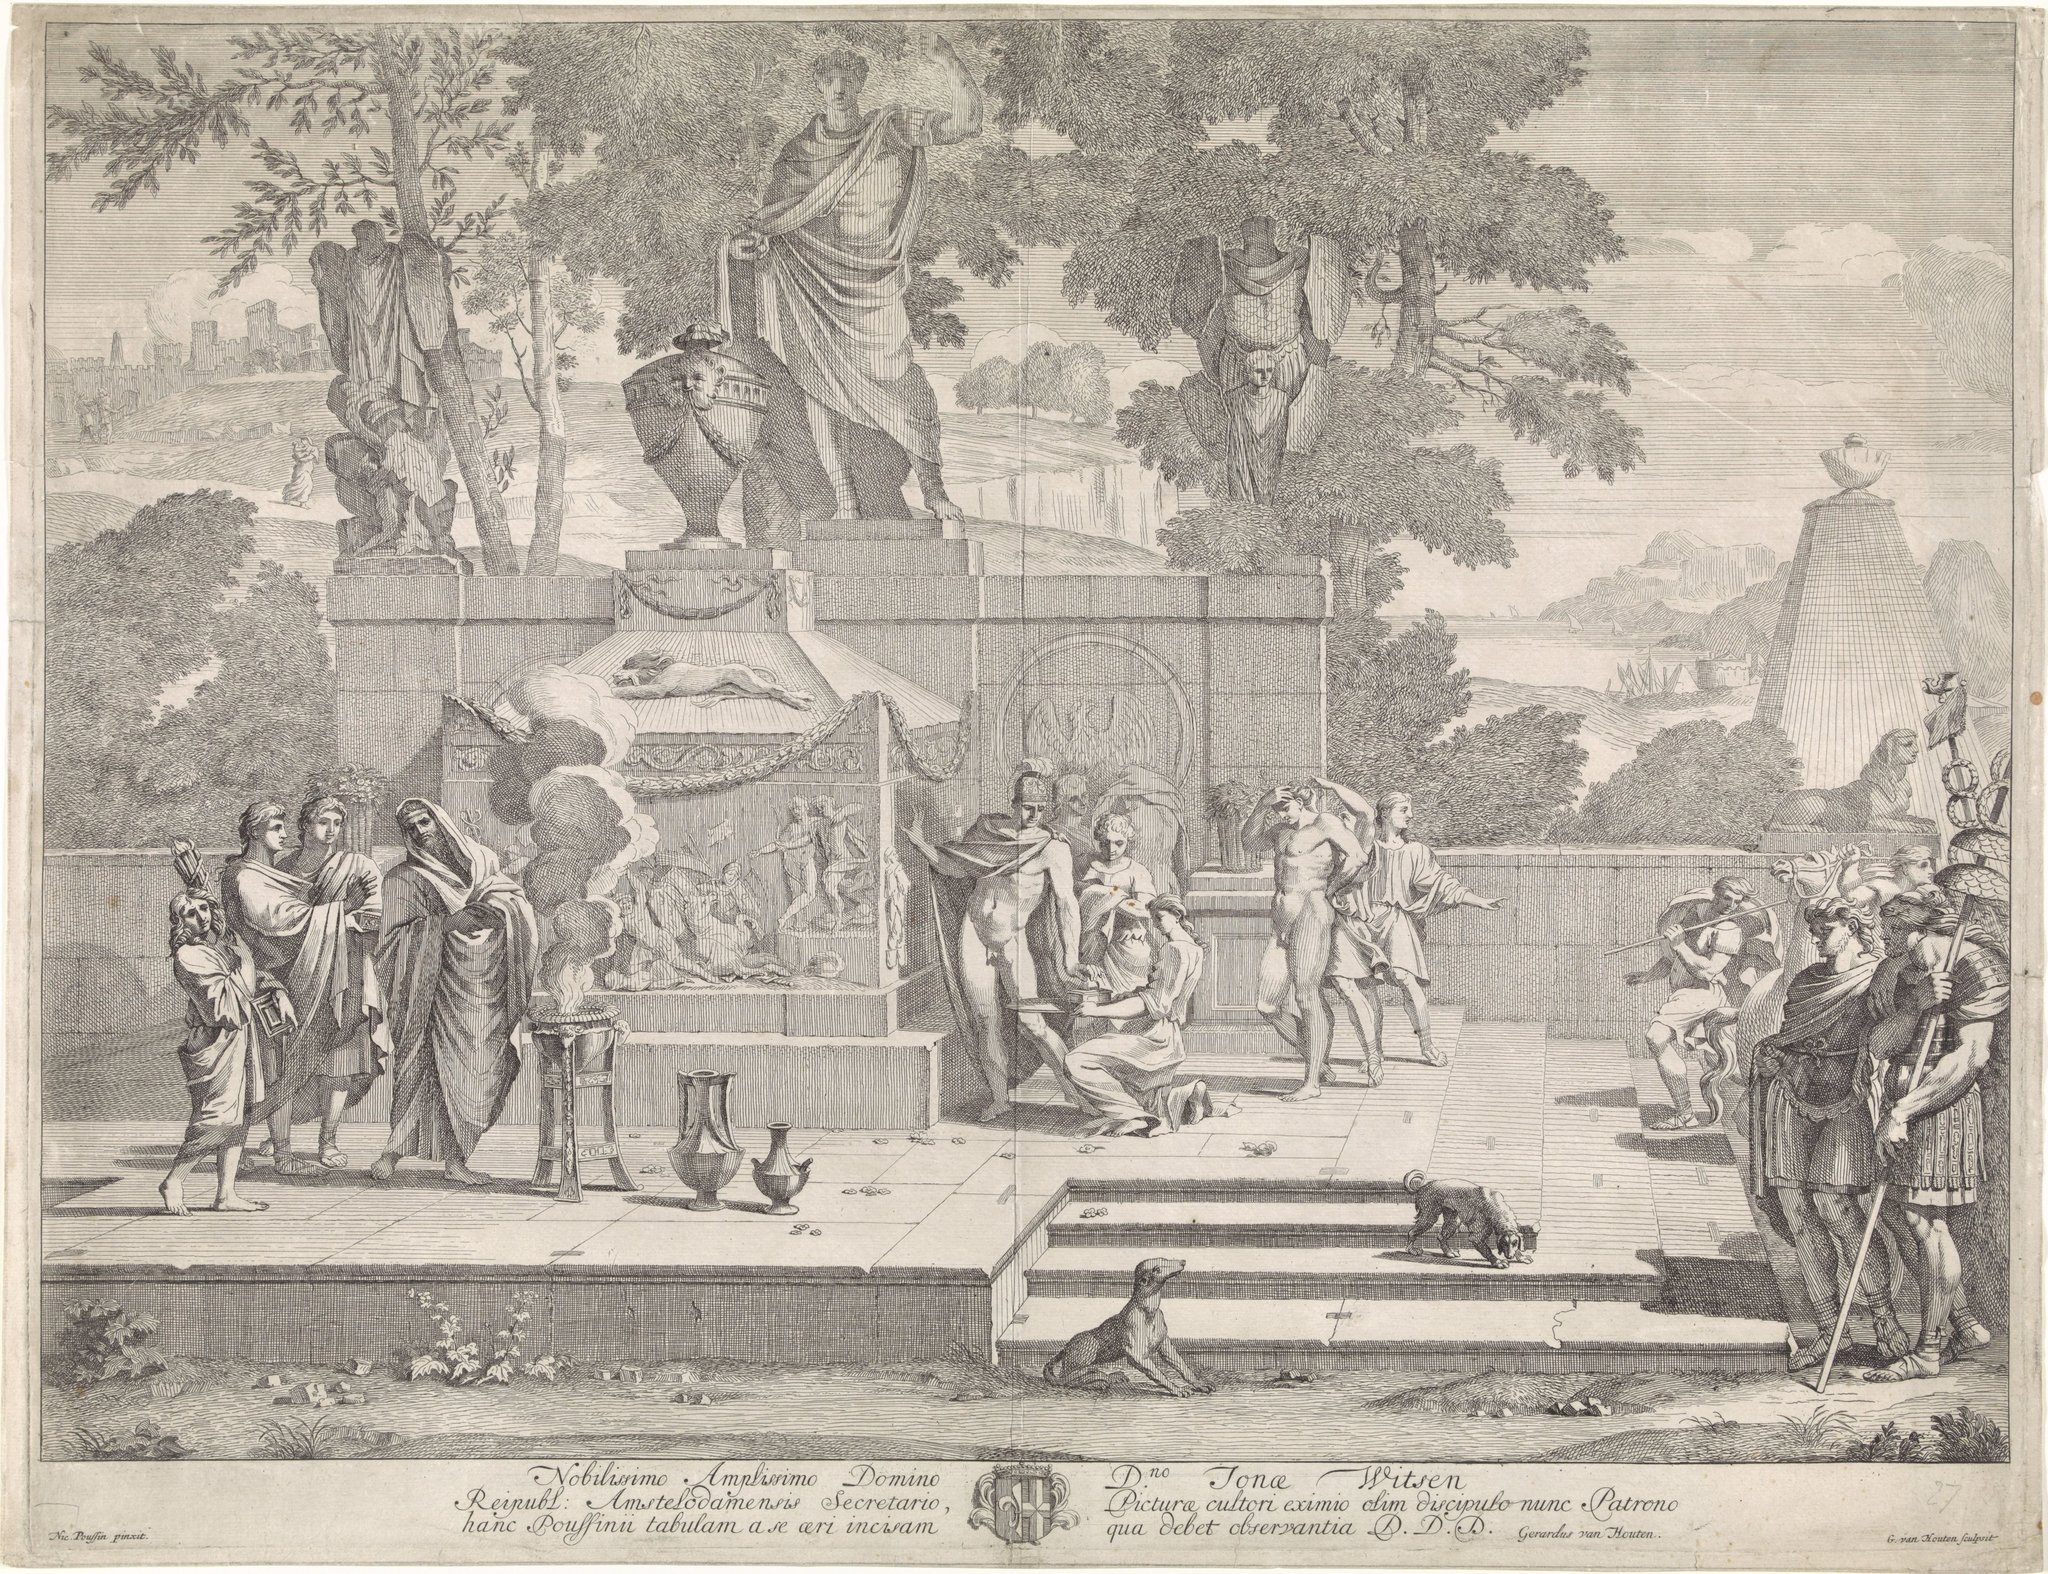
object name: print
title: Figuren bij een klassiek grafmonument: Caesar voor de tombe van Alexander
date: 1700-1706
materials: paper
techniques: etching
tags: events and situations from classical history, grave-building, monumental tomb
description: Vele Romeins geklede figuren een klassiek grafmonument.